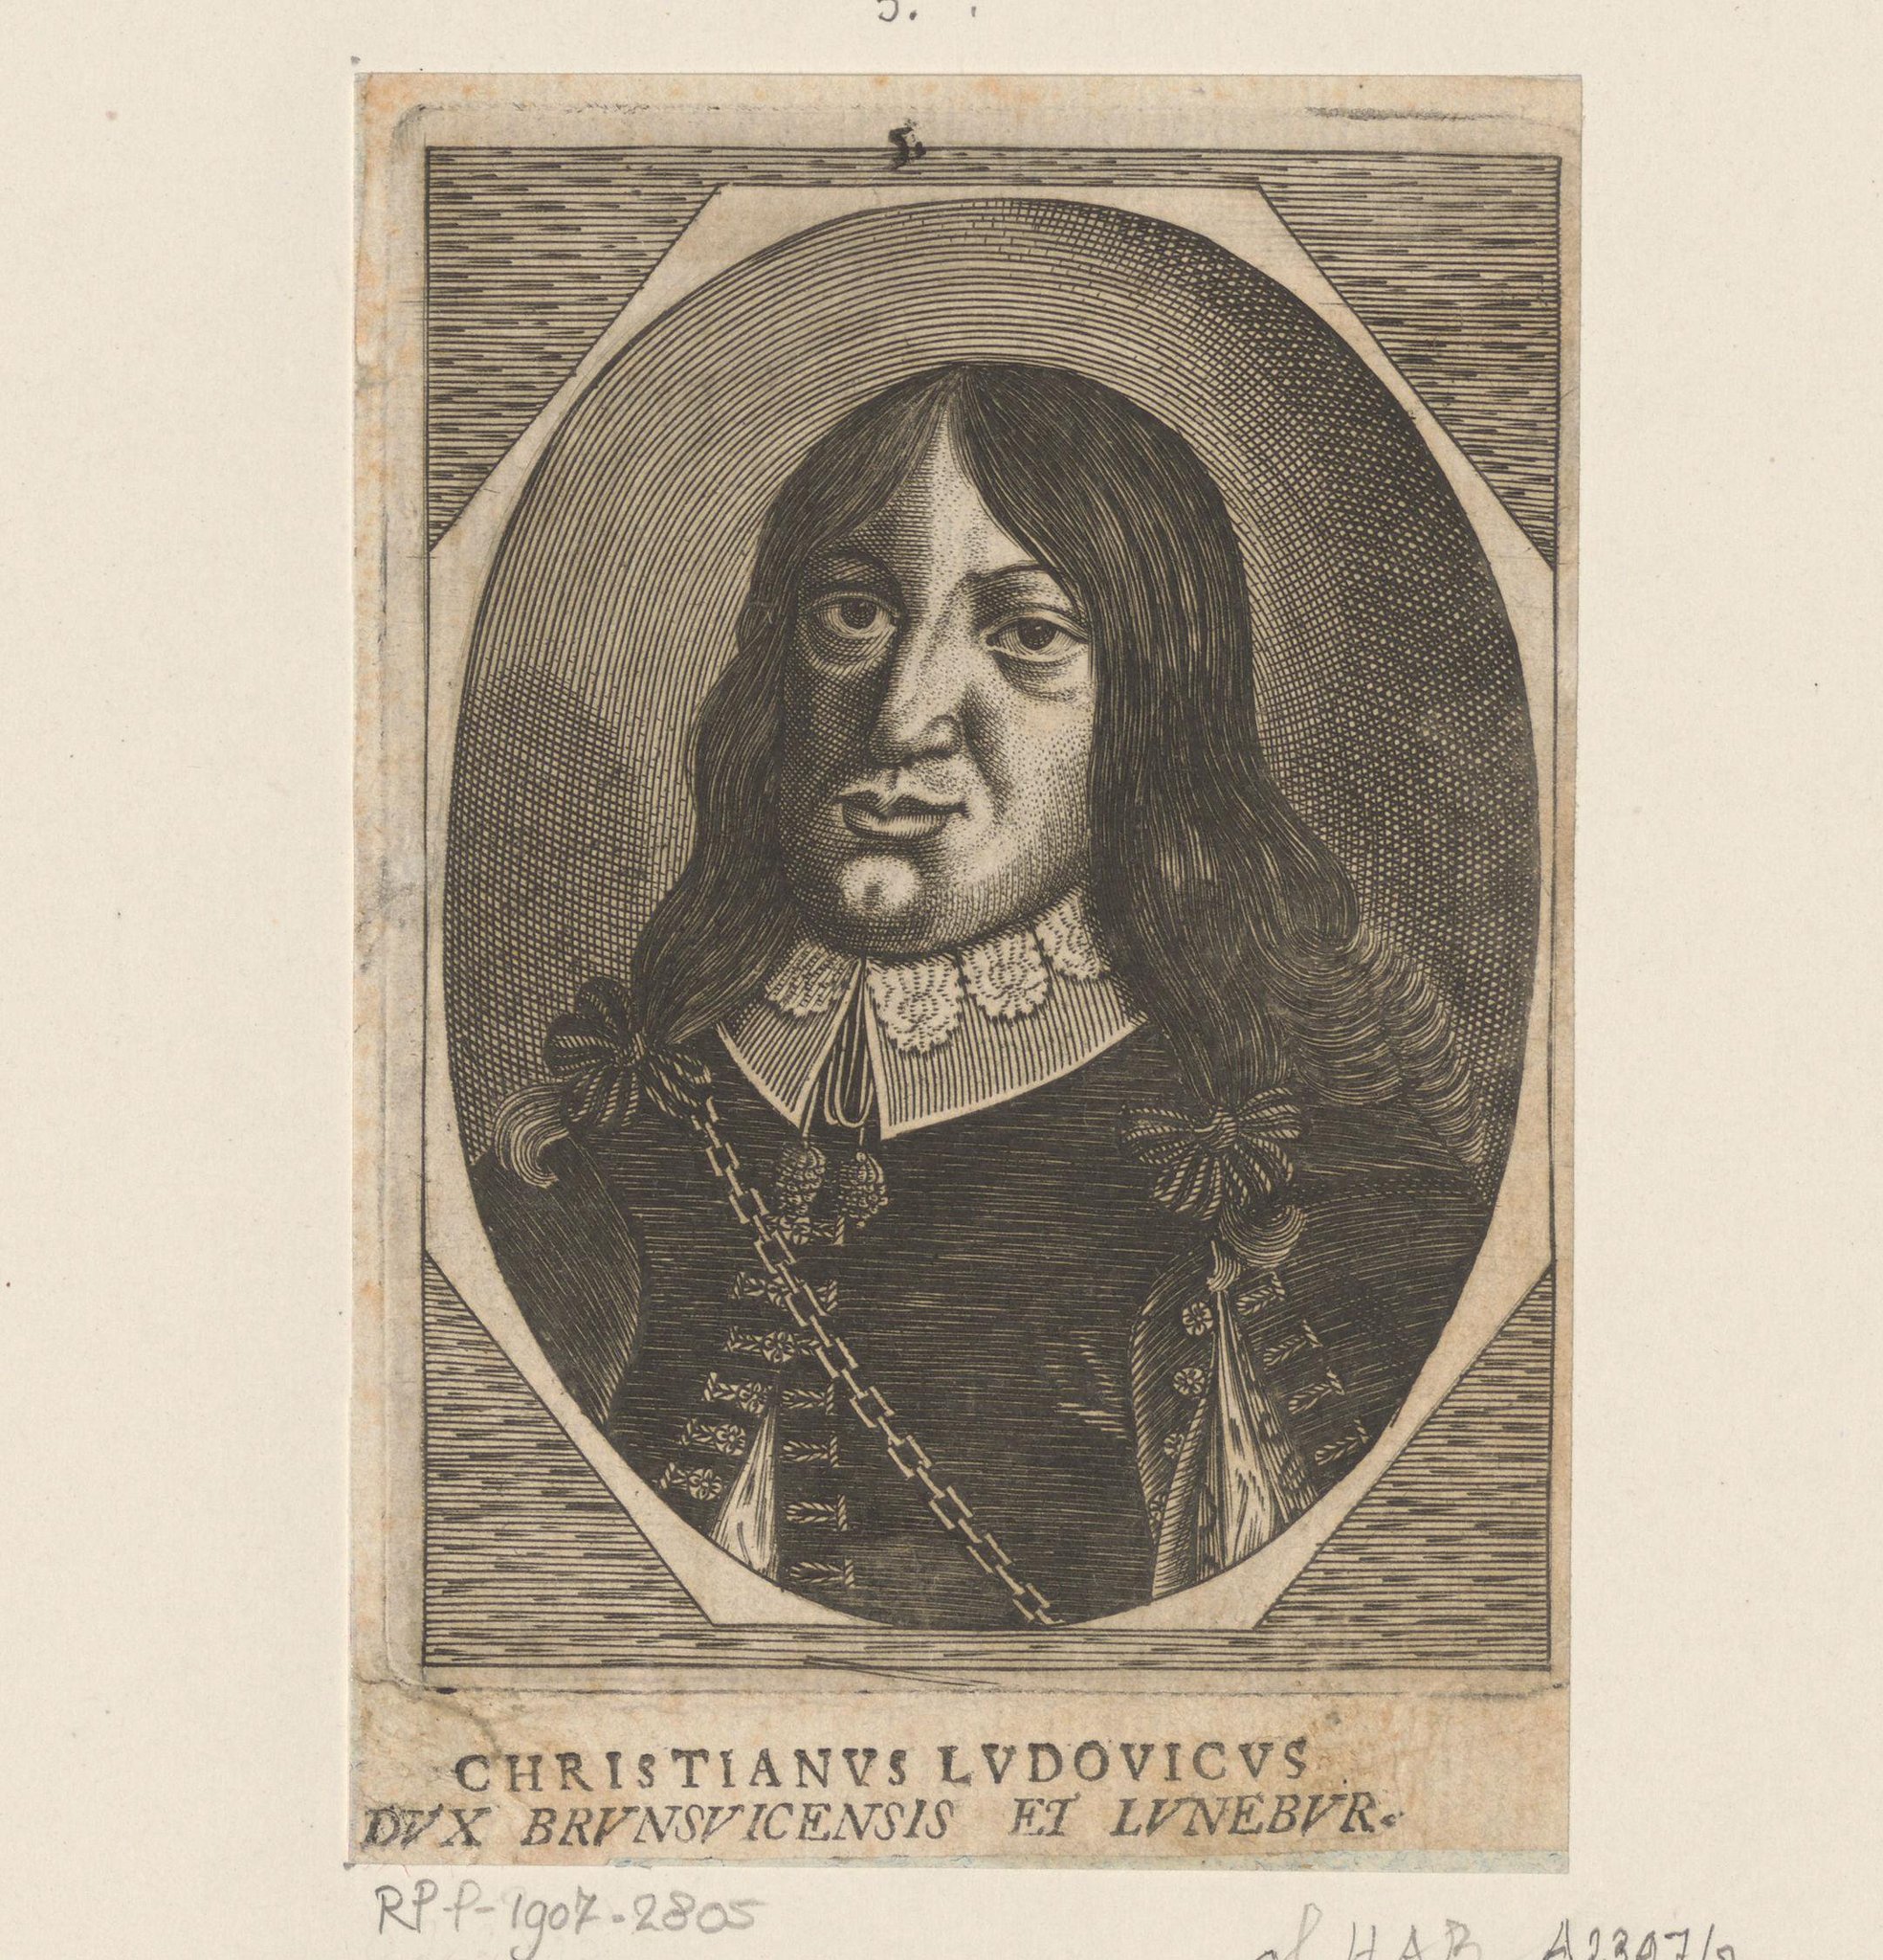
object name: print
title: Portret van Christiaan Lodewijk van Brunswijk-Lüneburg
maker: Anonymous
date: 1648-1699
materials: paper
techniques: engraving, letterpress printing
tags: historical persons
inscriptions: collector's mark: Lugt 2282